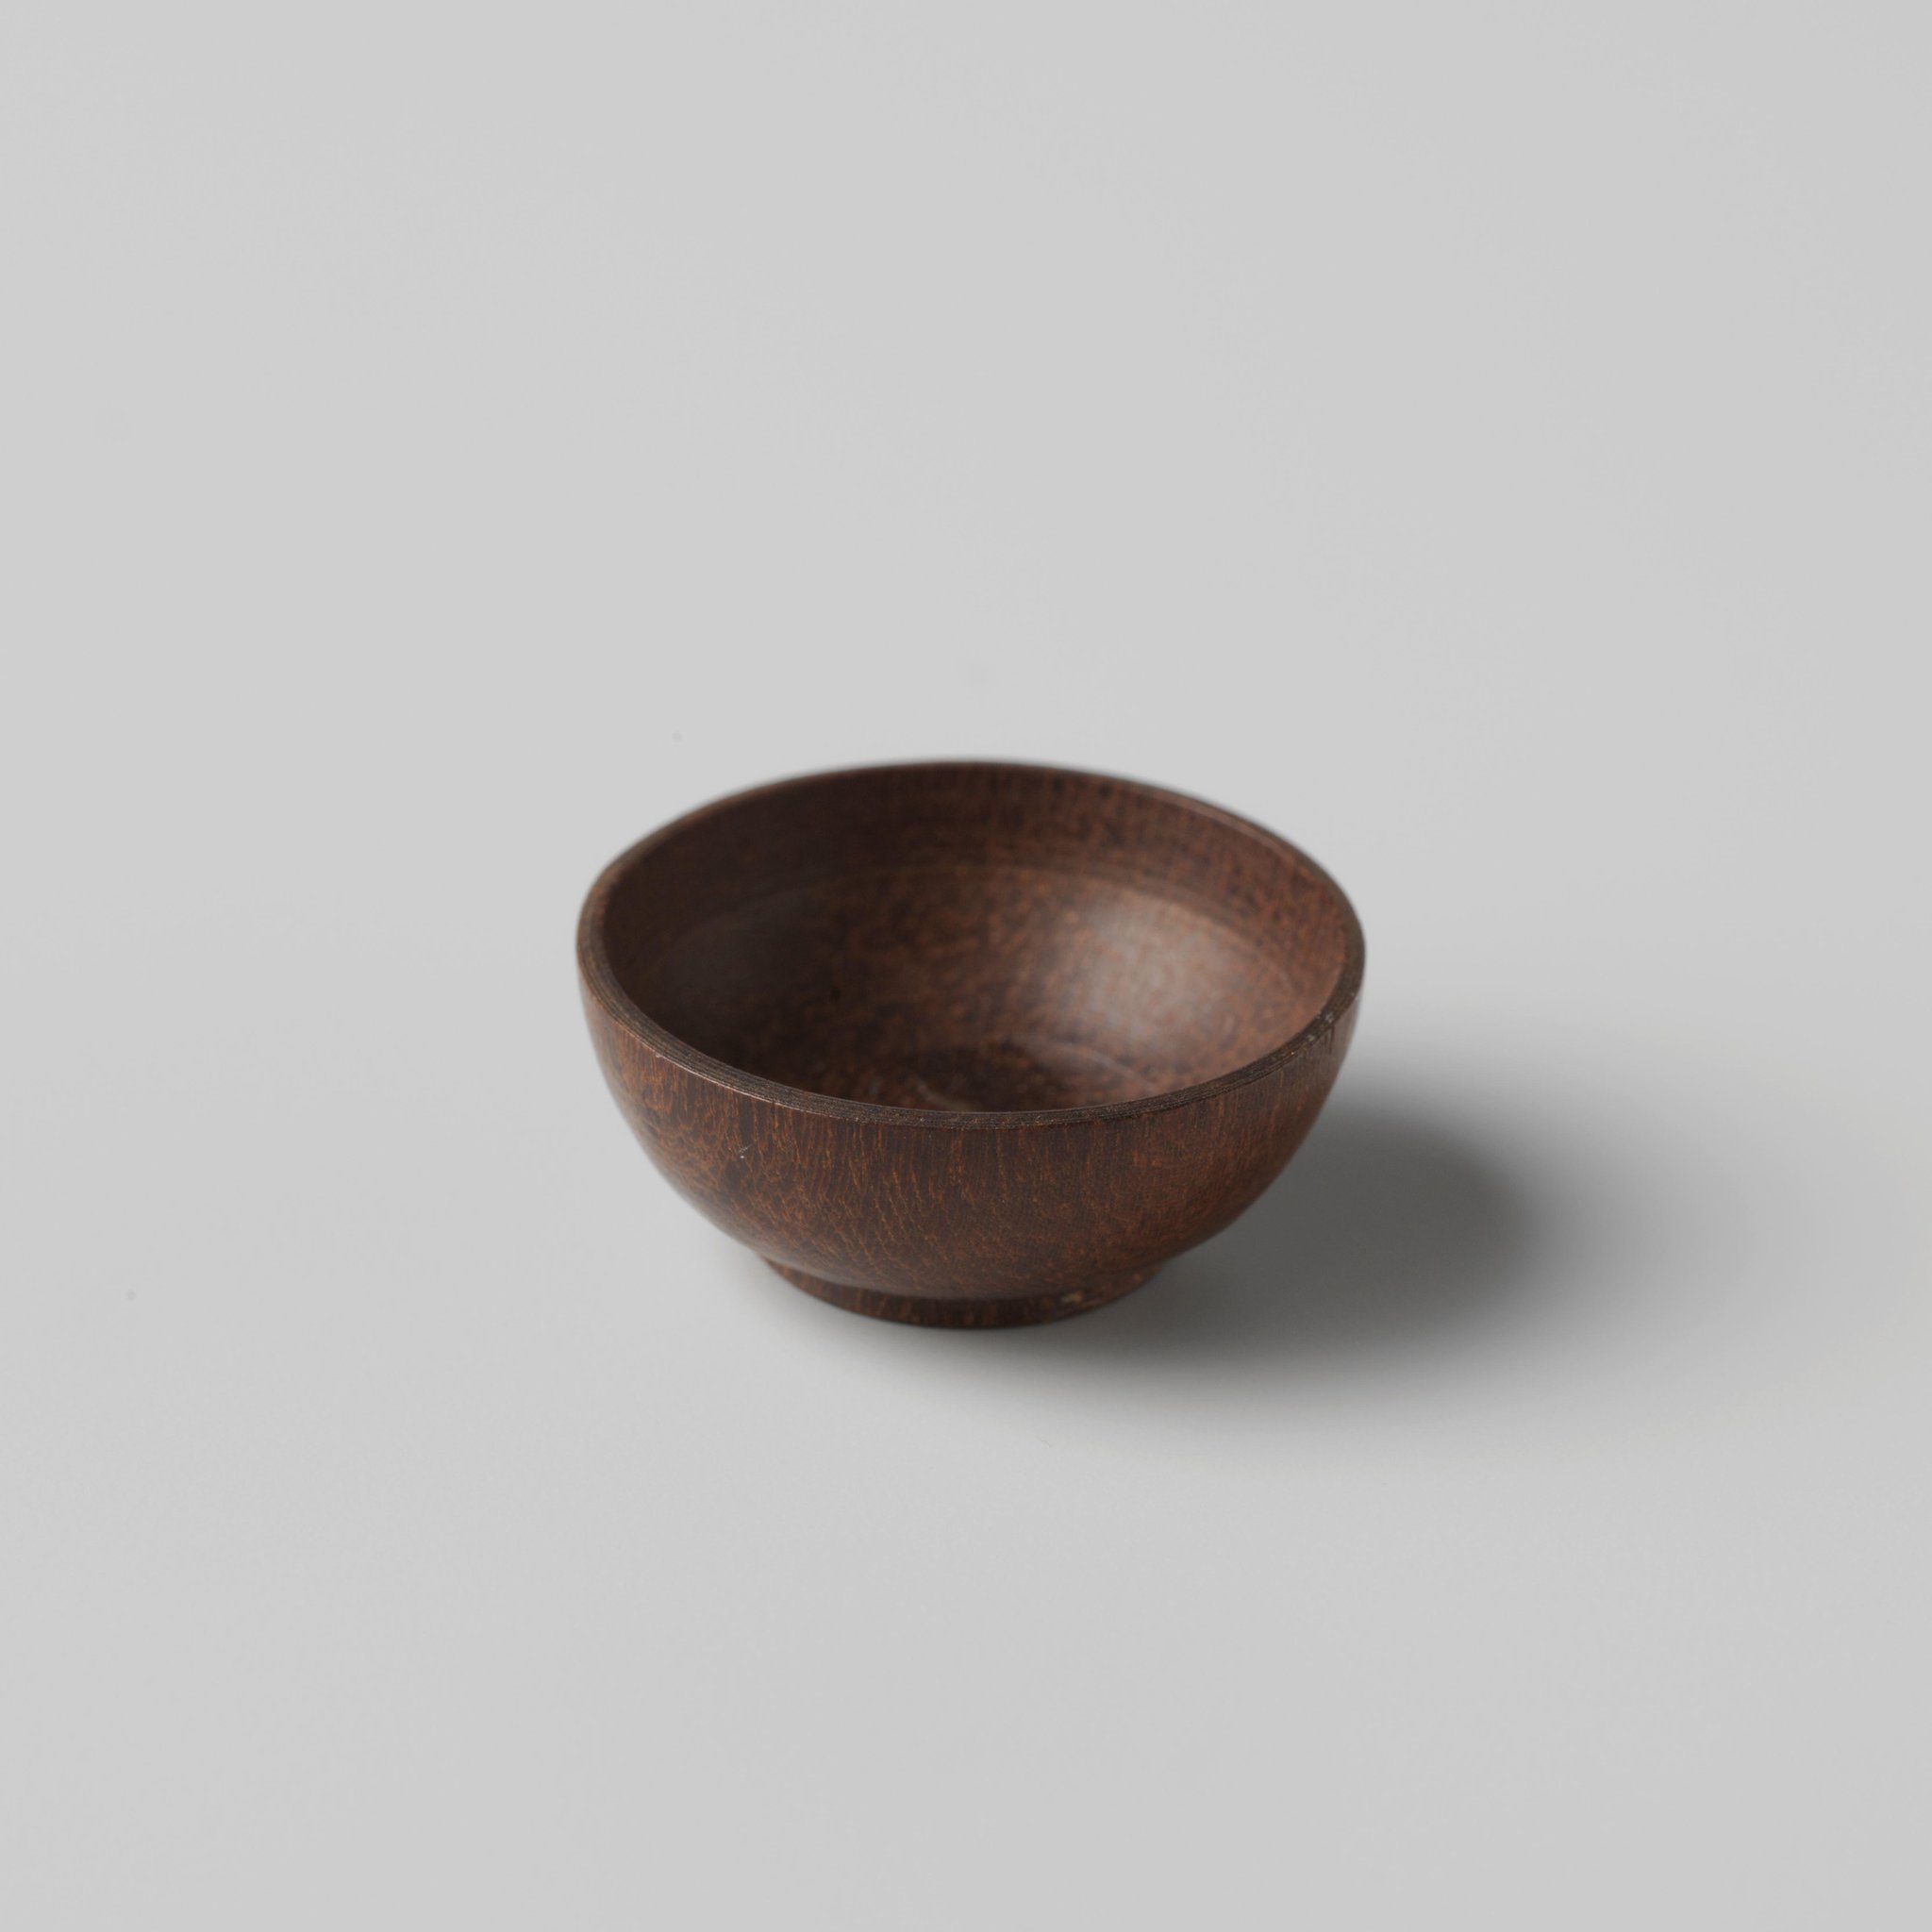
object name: miniature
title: Spoelkom van gedraaid hout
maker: Anonymous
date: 1800-1899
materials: wood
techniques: tropisch hardhout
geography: england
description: Spoelkom gedraaid van een donkere hardhoutsoort.